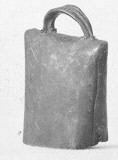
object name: pocketbook shaped rattle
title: Pocketbook-shaped rattle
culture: bakwe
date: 1701-1800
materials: metal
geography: liberia-ivory coast border